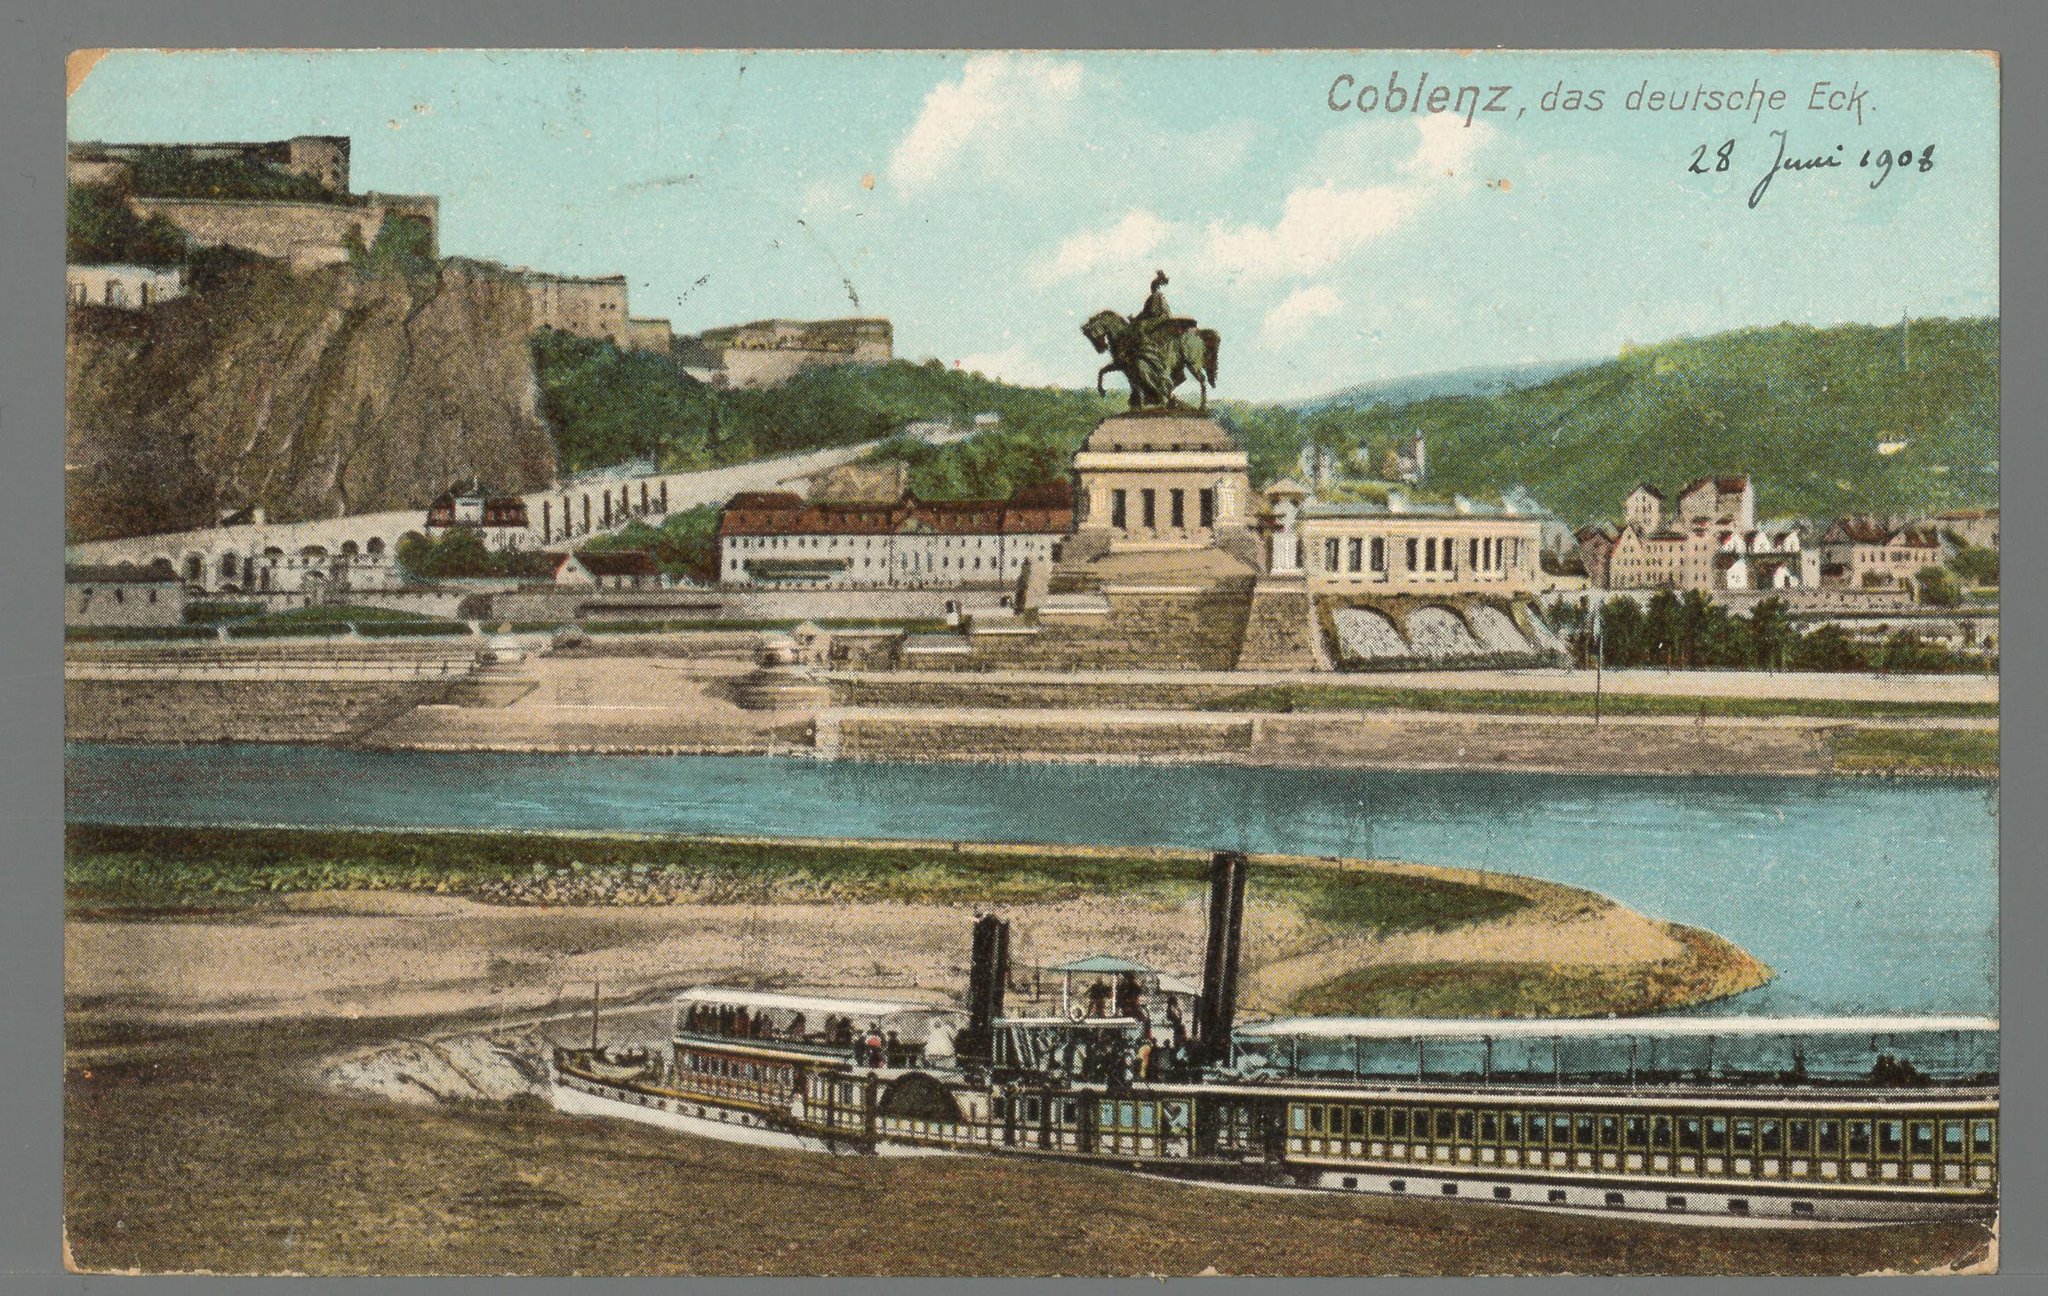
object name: ansichtkaart, prentbriefkaart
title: Coblenz, das deutsche Eck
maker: ottmar zieher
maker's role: publisher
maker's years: 1857-1924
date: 1905-1908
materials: cardboard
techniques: lithograph, writing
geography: munich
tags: berlin, wilhelm i (keizer van duitsland), monument, statue, canals, waters (in city)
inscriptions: postage stamp